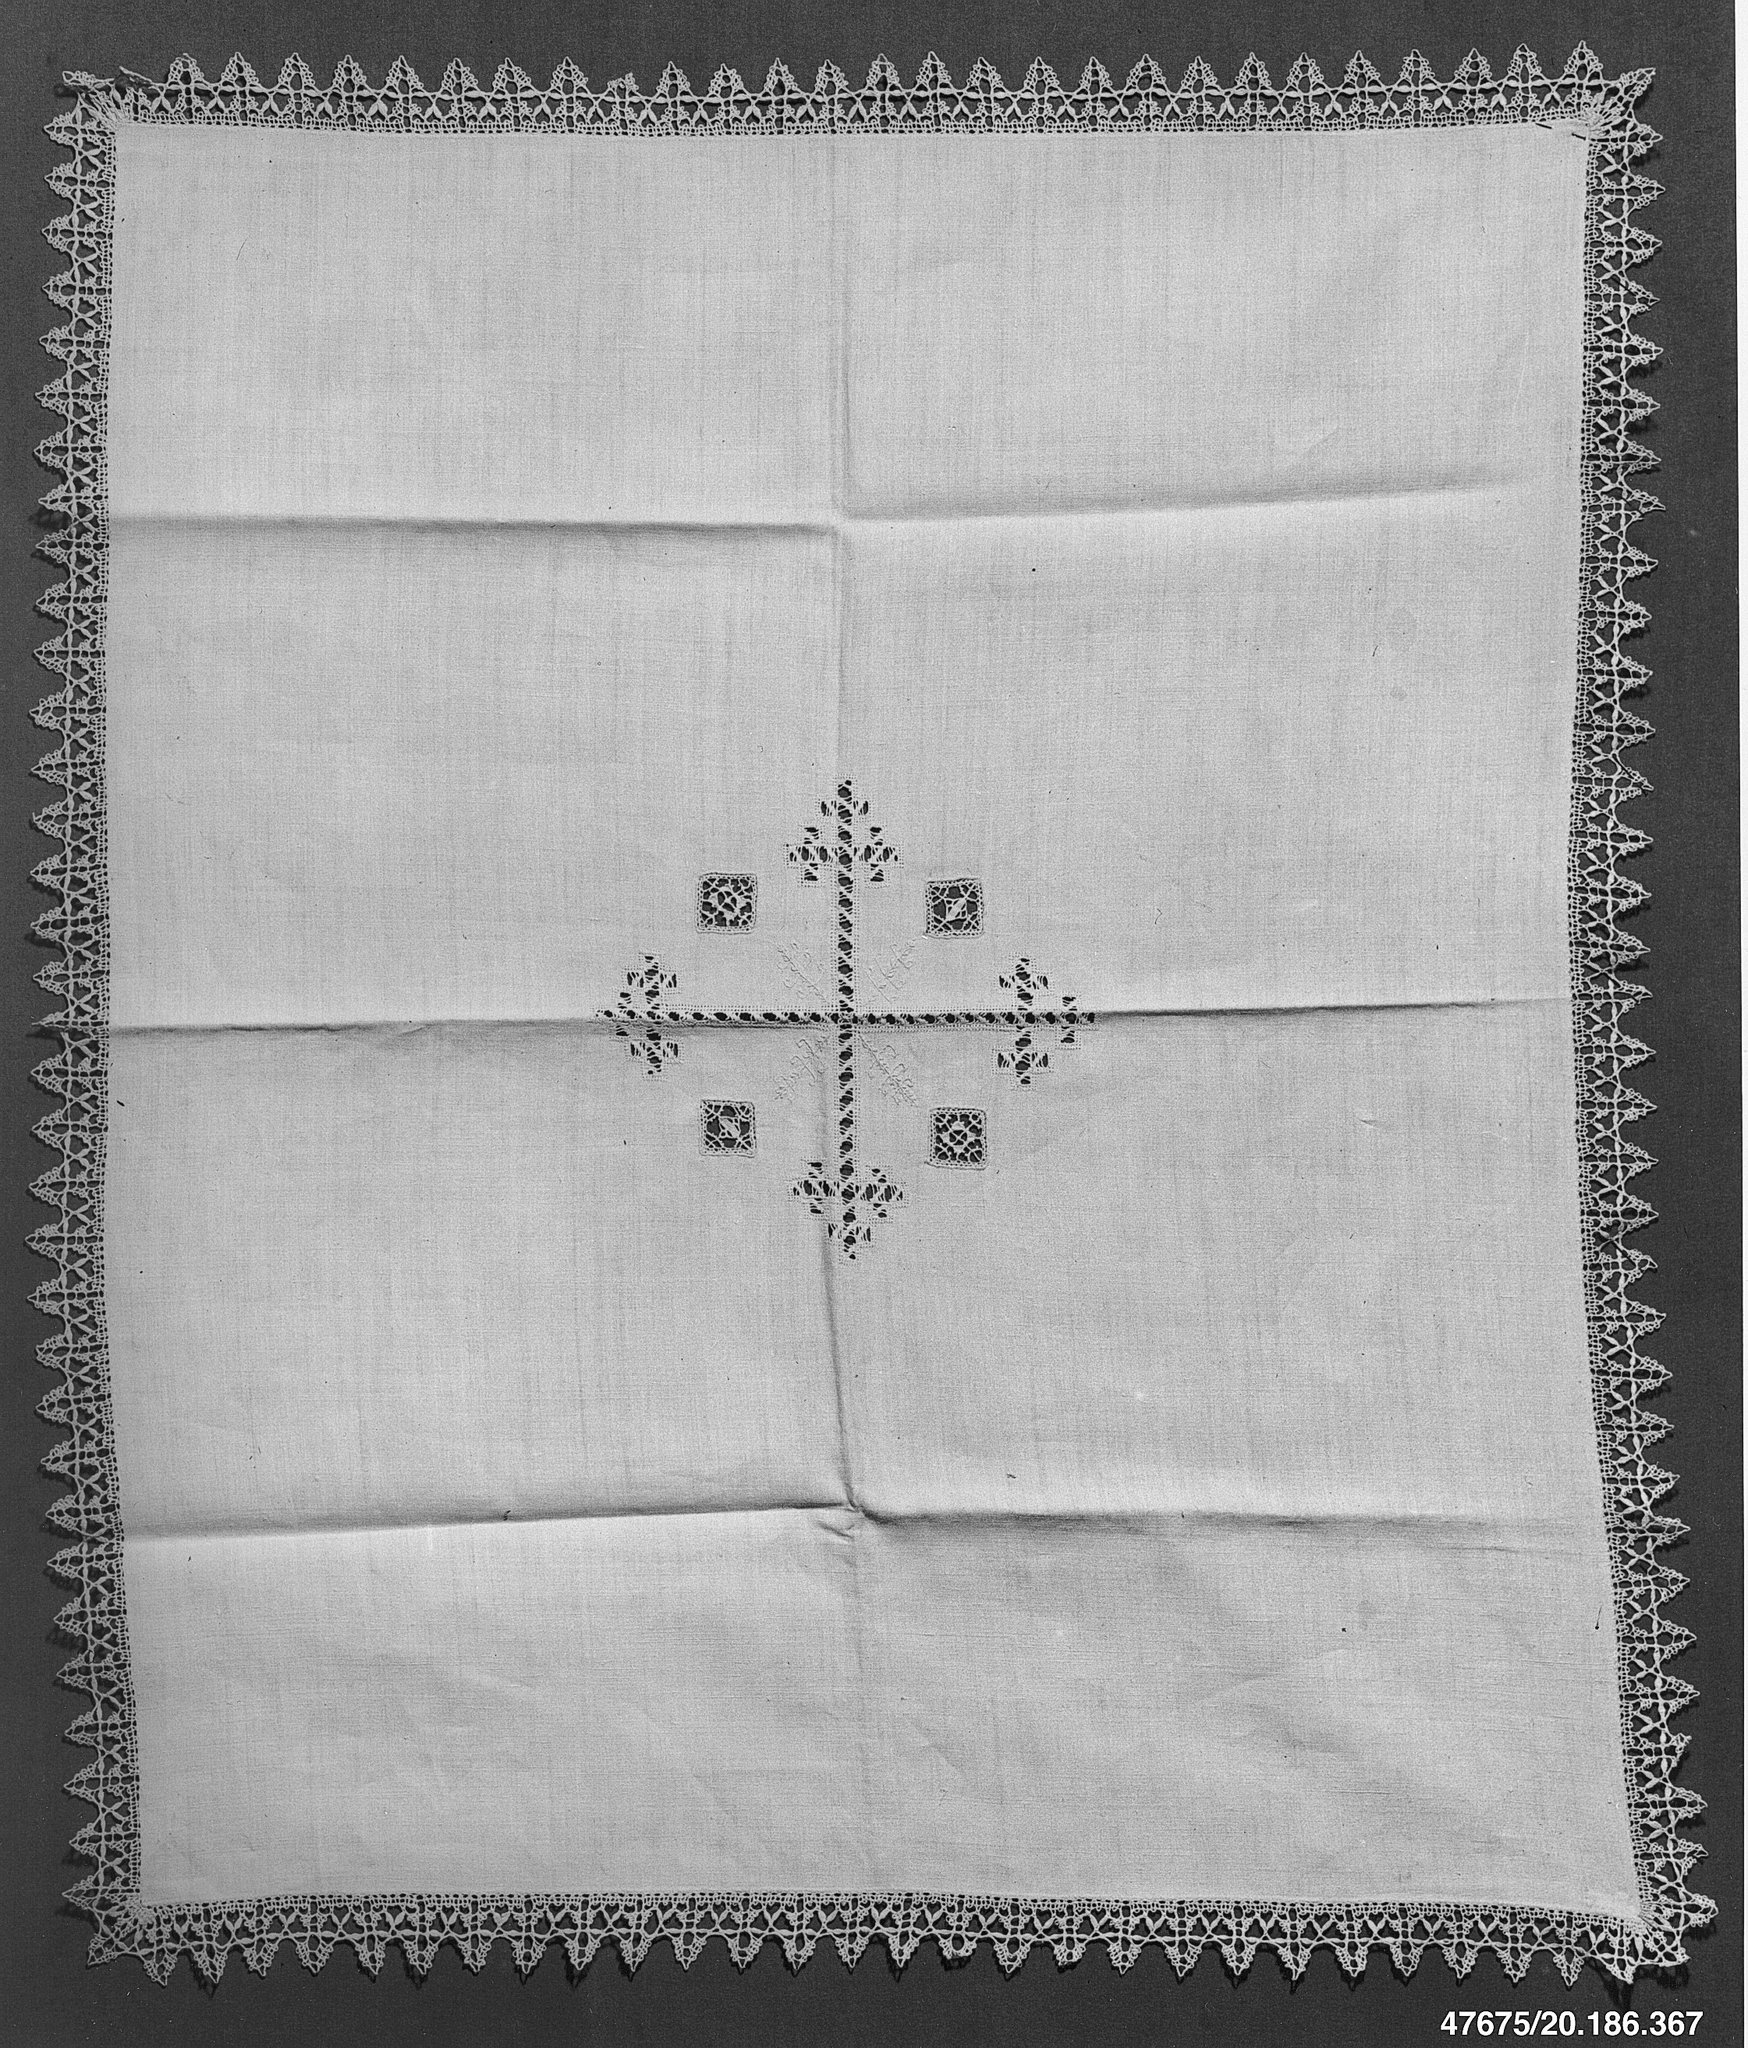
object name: chalice cover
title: Chalice veil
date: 1601-1700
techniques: embroidery